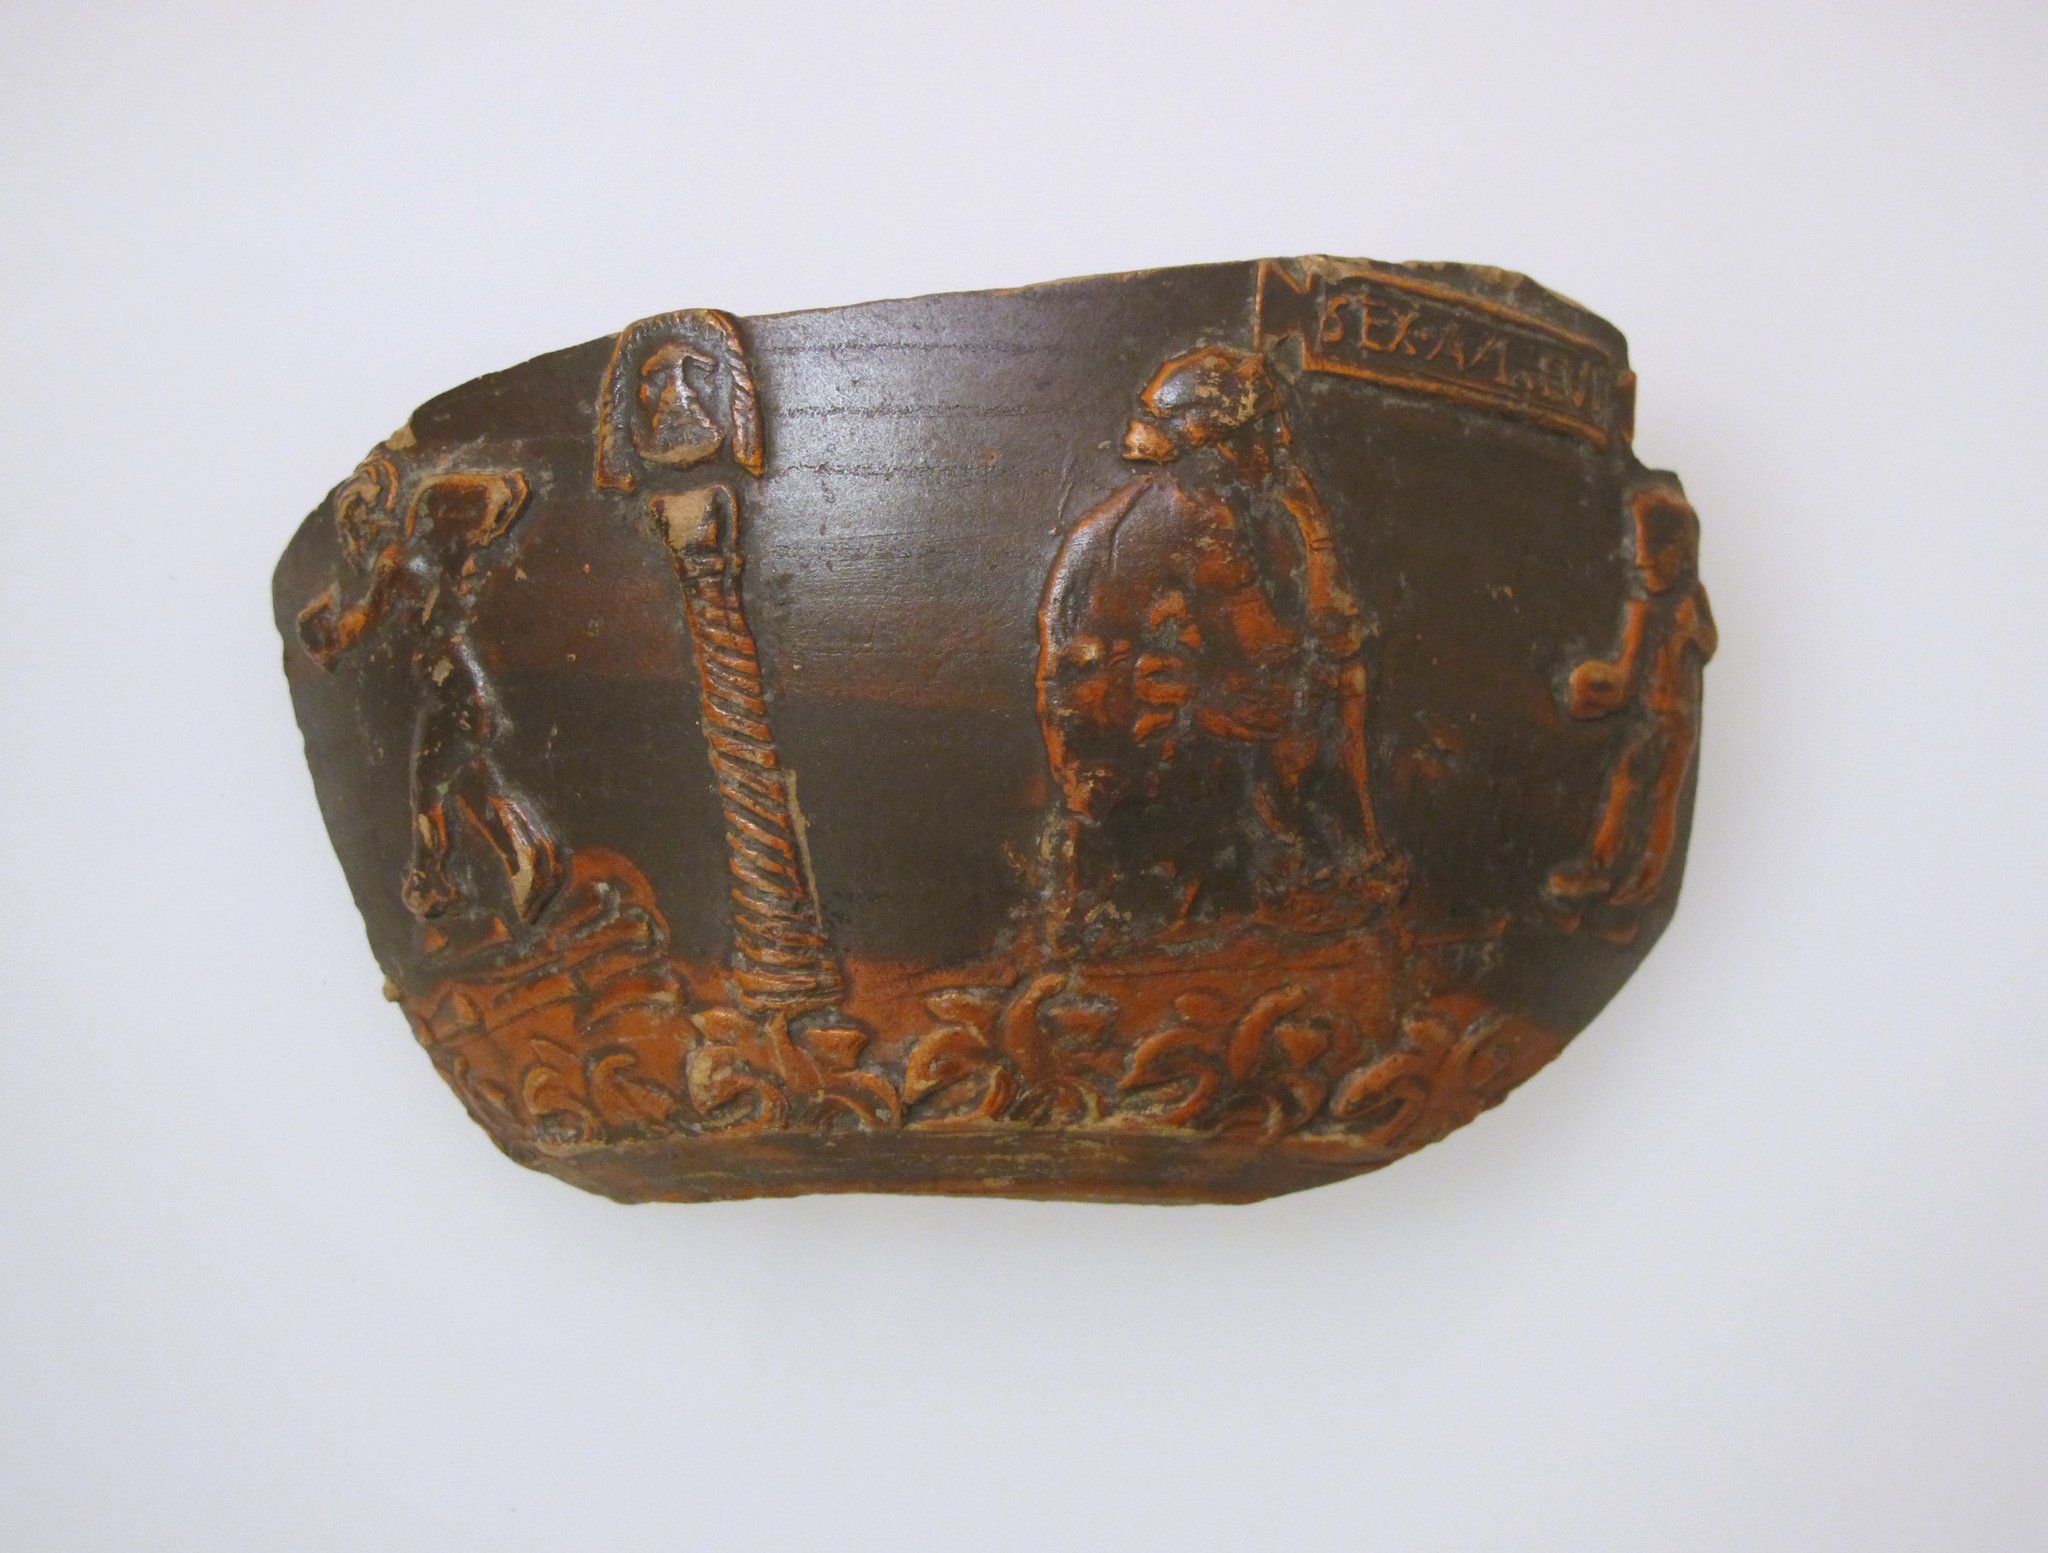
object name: fragment of a bowl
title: Terracotta bowl fragment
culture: roman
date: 10 BCE-20 CE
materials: terracotta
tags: columns,masks,women,cupid